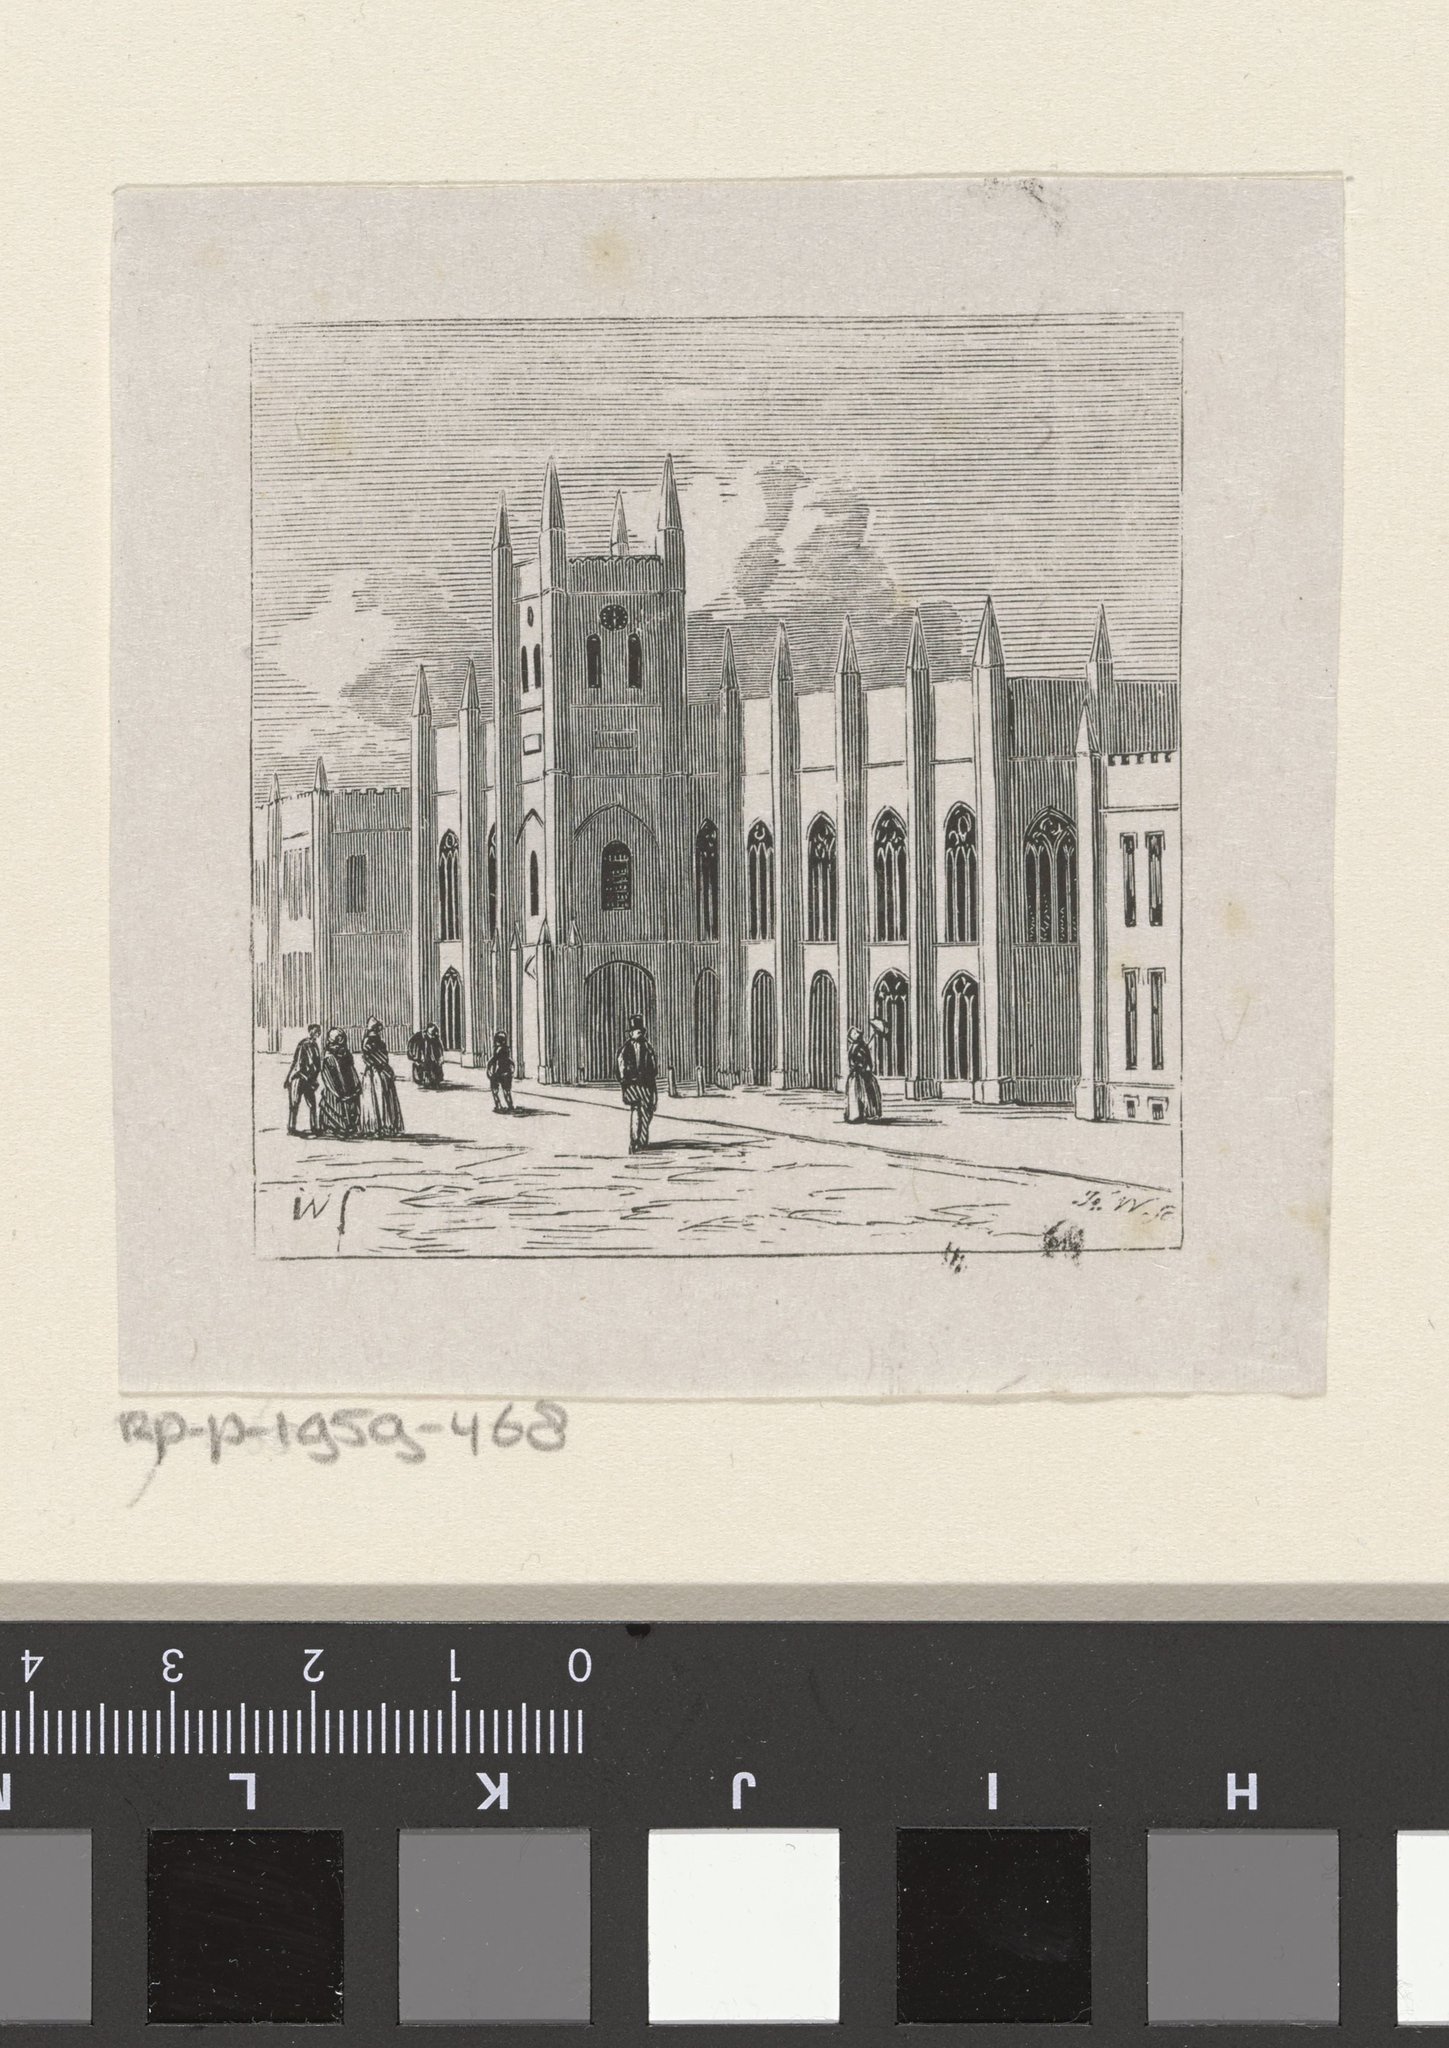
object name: print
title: Gezicht op de Gotische Zaal te Den Haag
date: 1836-1912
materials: paper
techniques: engraving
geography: netherlands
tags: square, place, circus, etc. (+ city(-scape) with figures, staffage), the hague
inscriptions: collector's mark: Lugt 2228